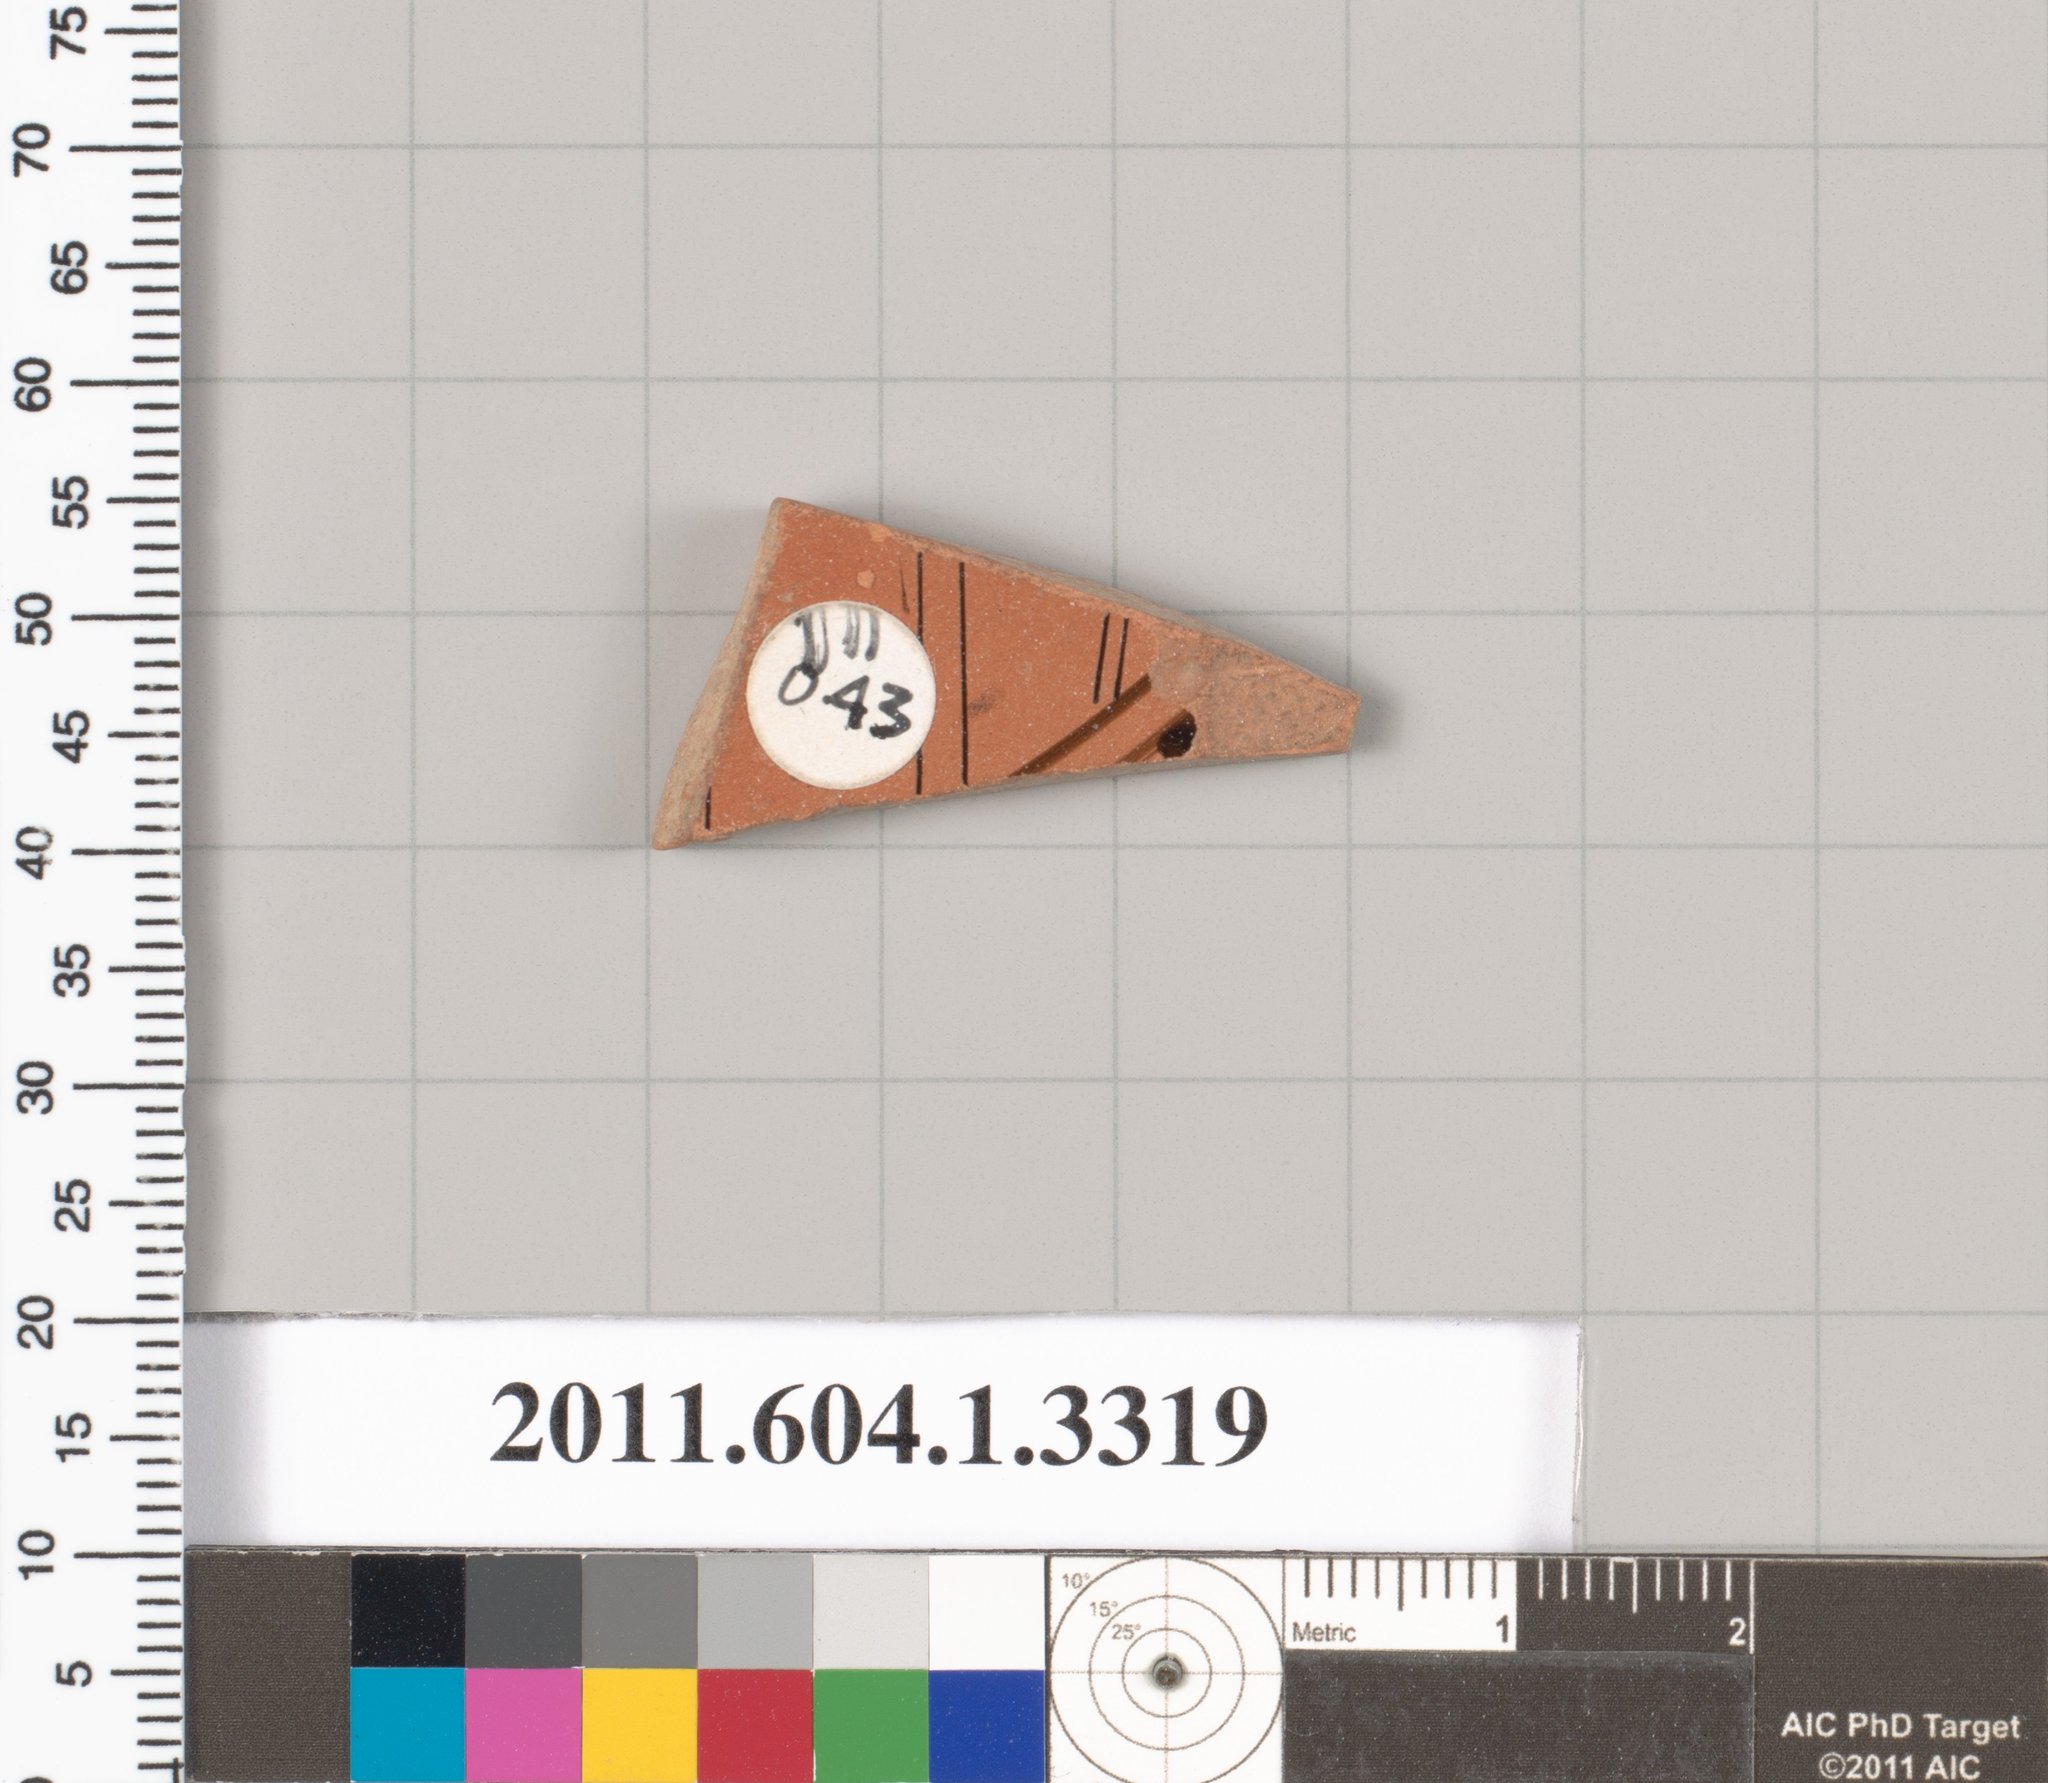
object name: kylix fragment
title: Terracotta fragment of a kylix (drinking cup)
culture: greek, attic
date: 475-451 BCE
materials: terracotta